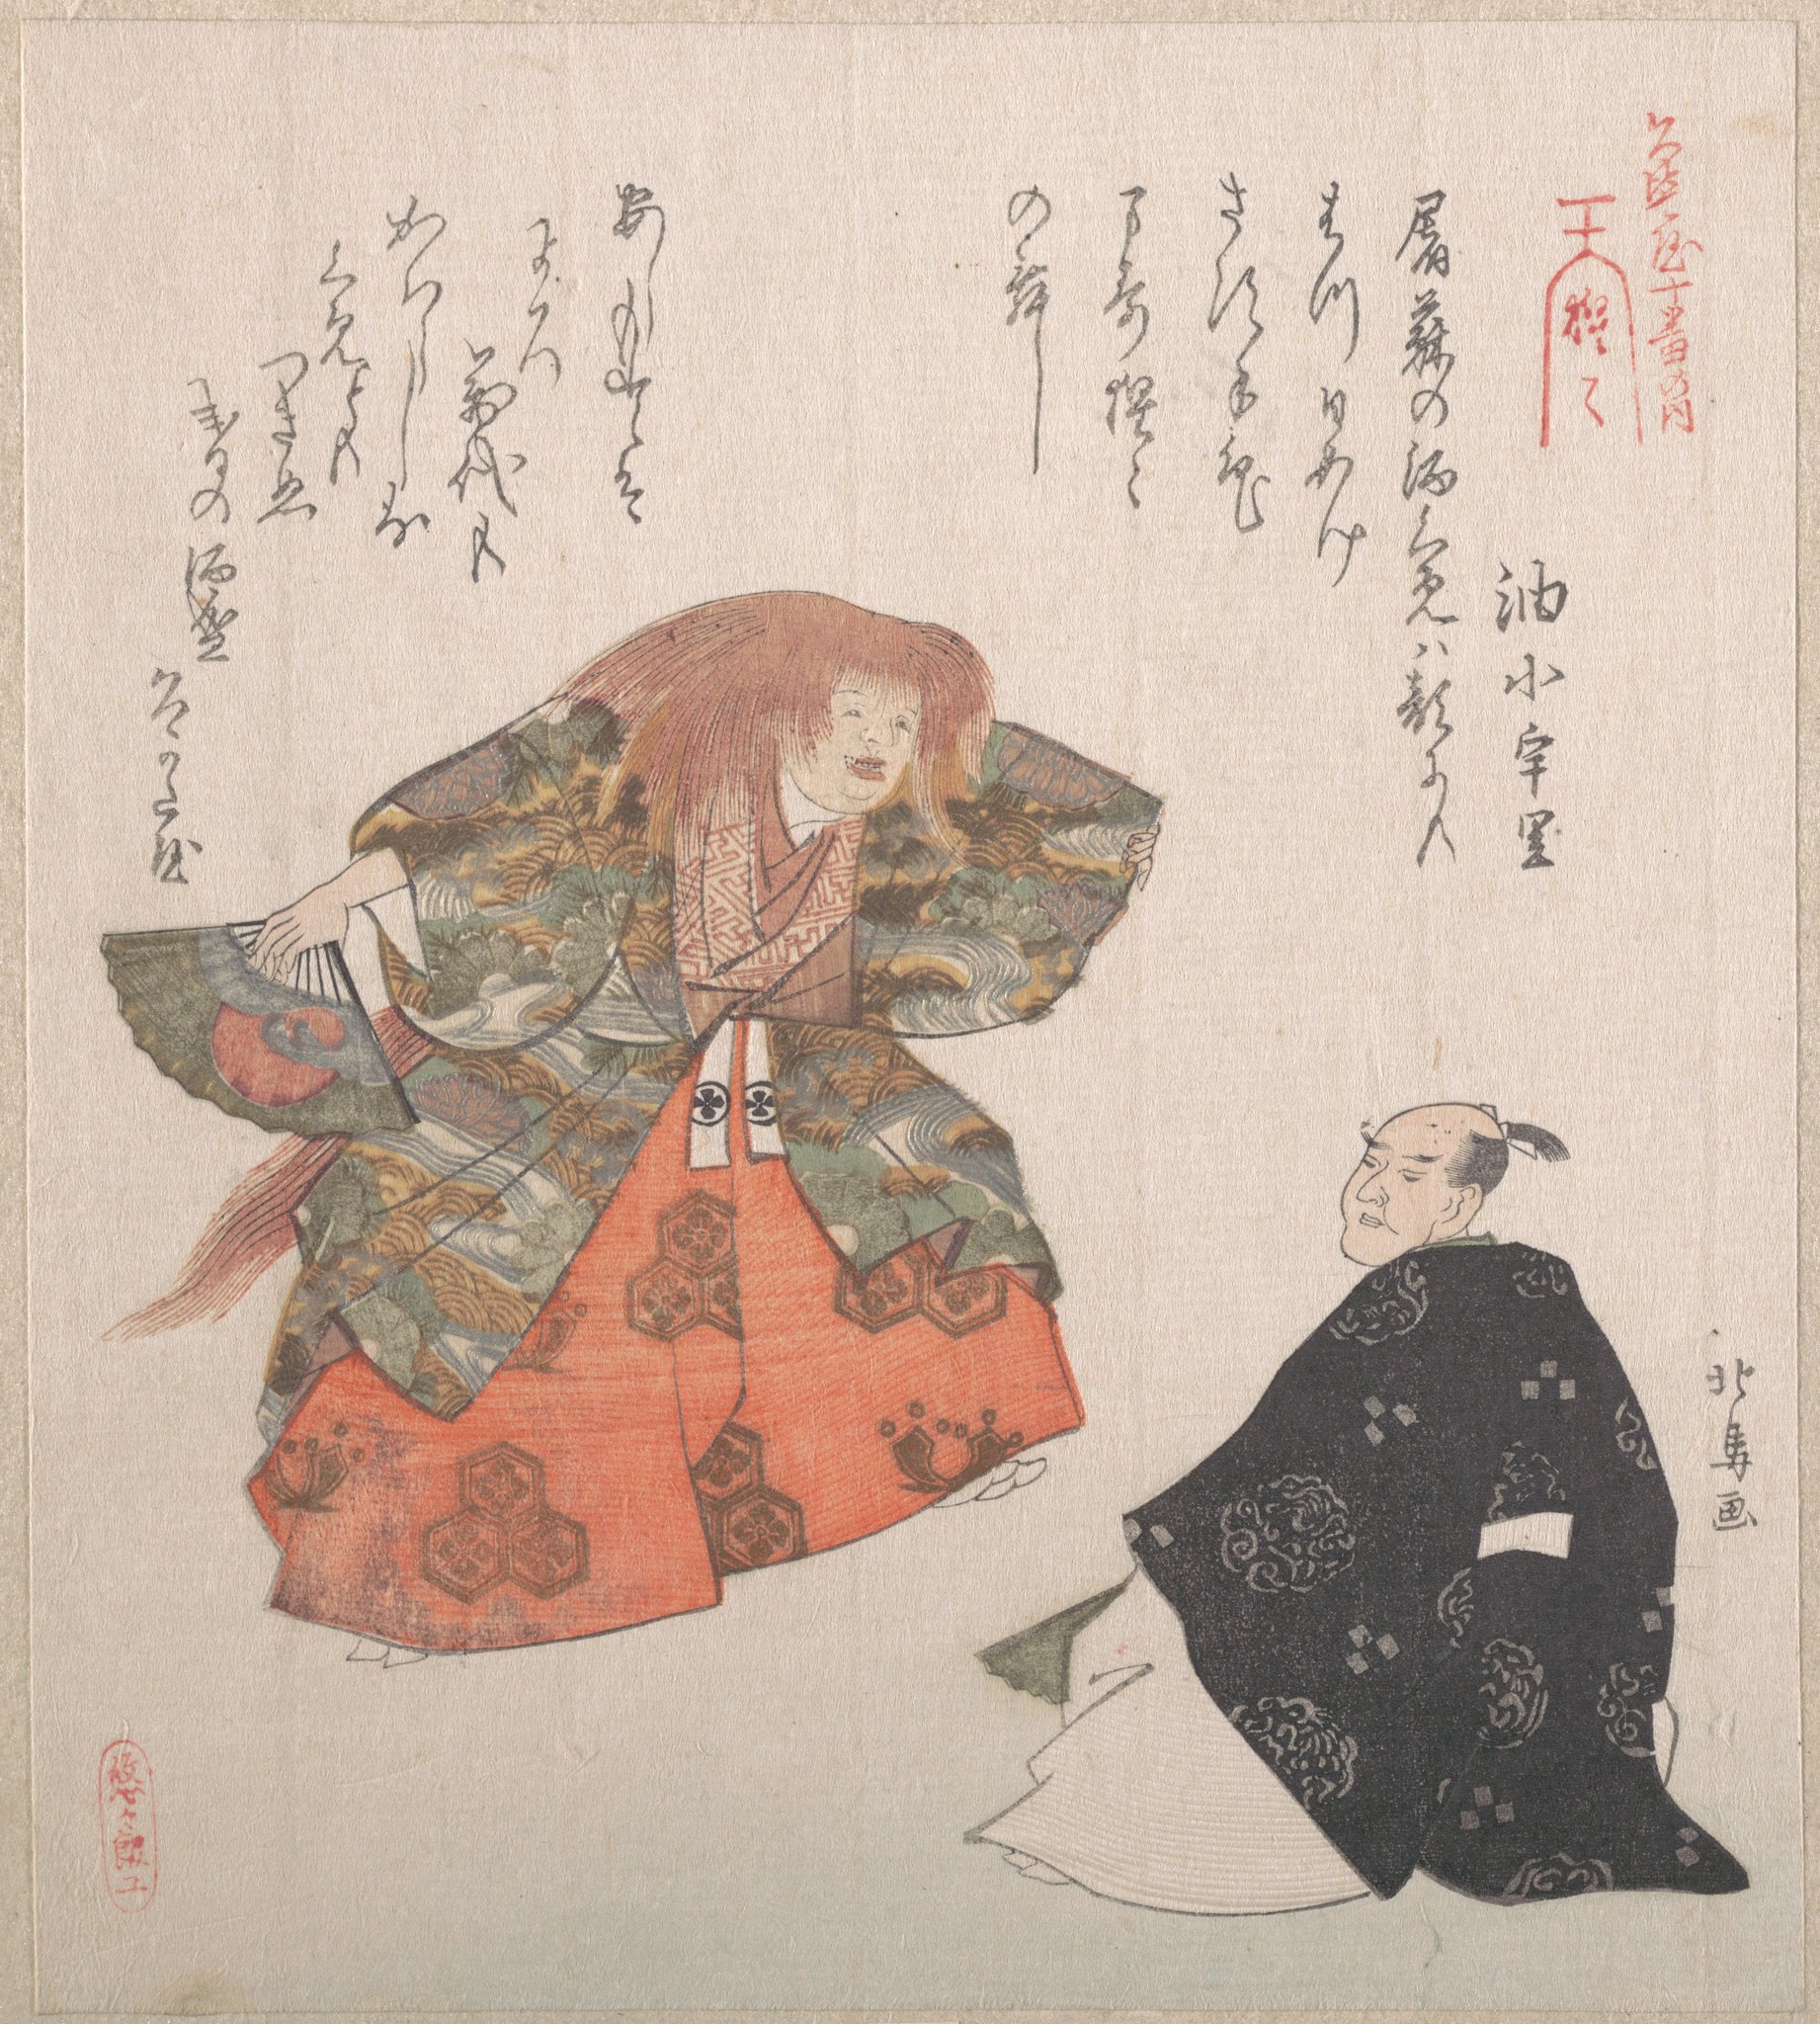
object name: print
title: Scene from the Noh Dance "Shojo"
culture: japanese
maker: teisai hokuba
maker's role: artist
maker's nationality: japanese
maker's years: 1771-1844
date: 1801-1900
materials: ink, paper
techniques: surimono, woodblock print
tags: dance,fans,men